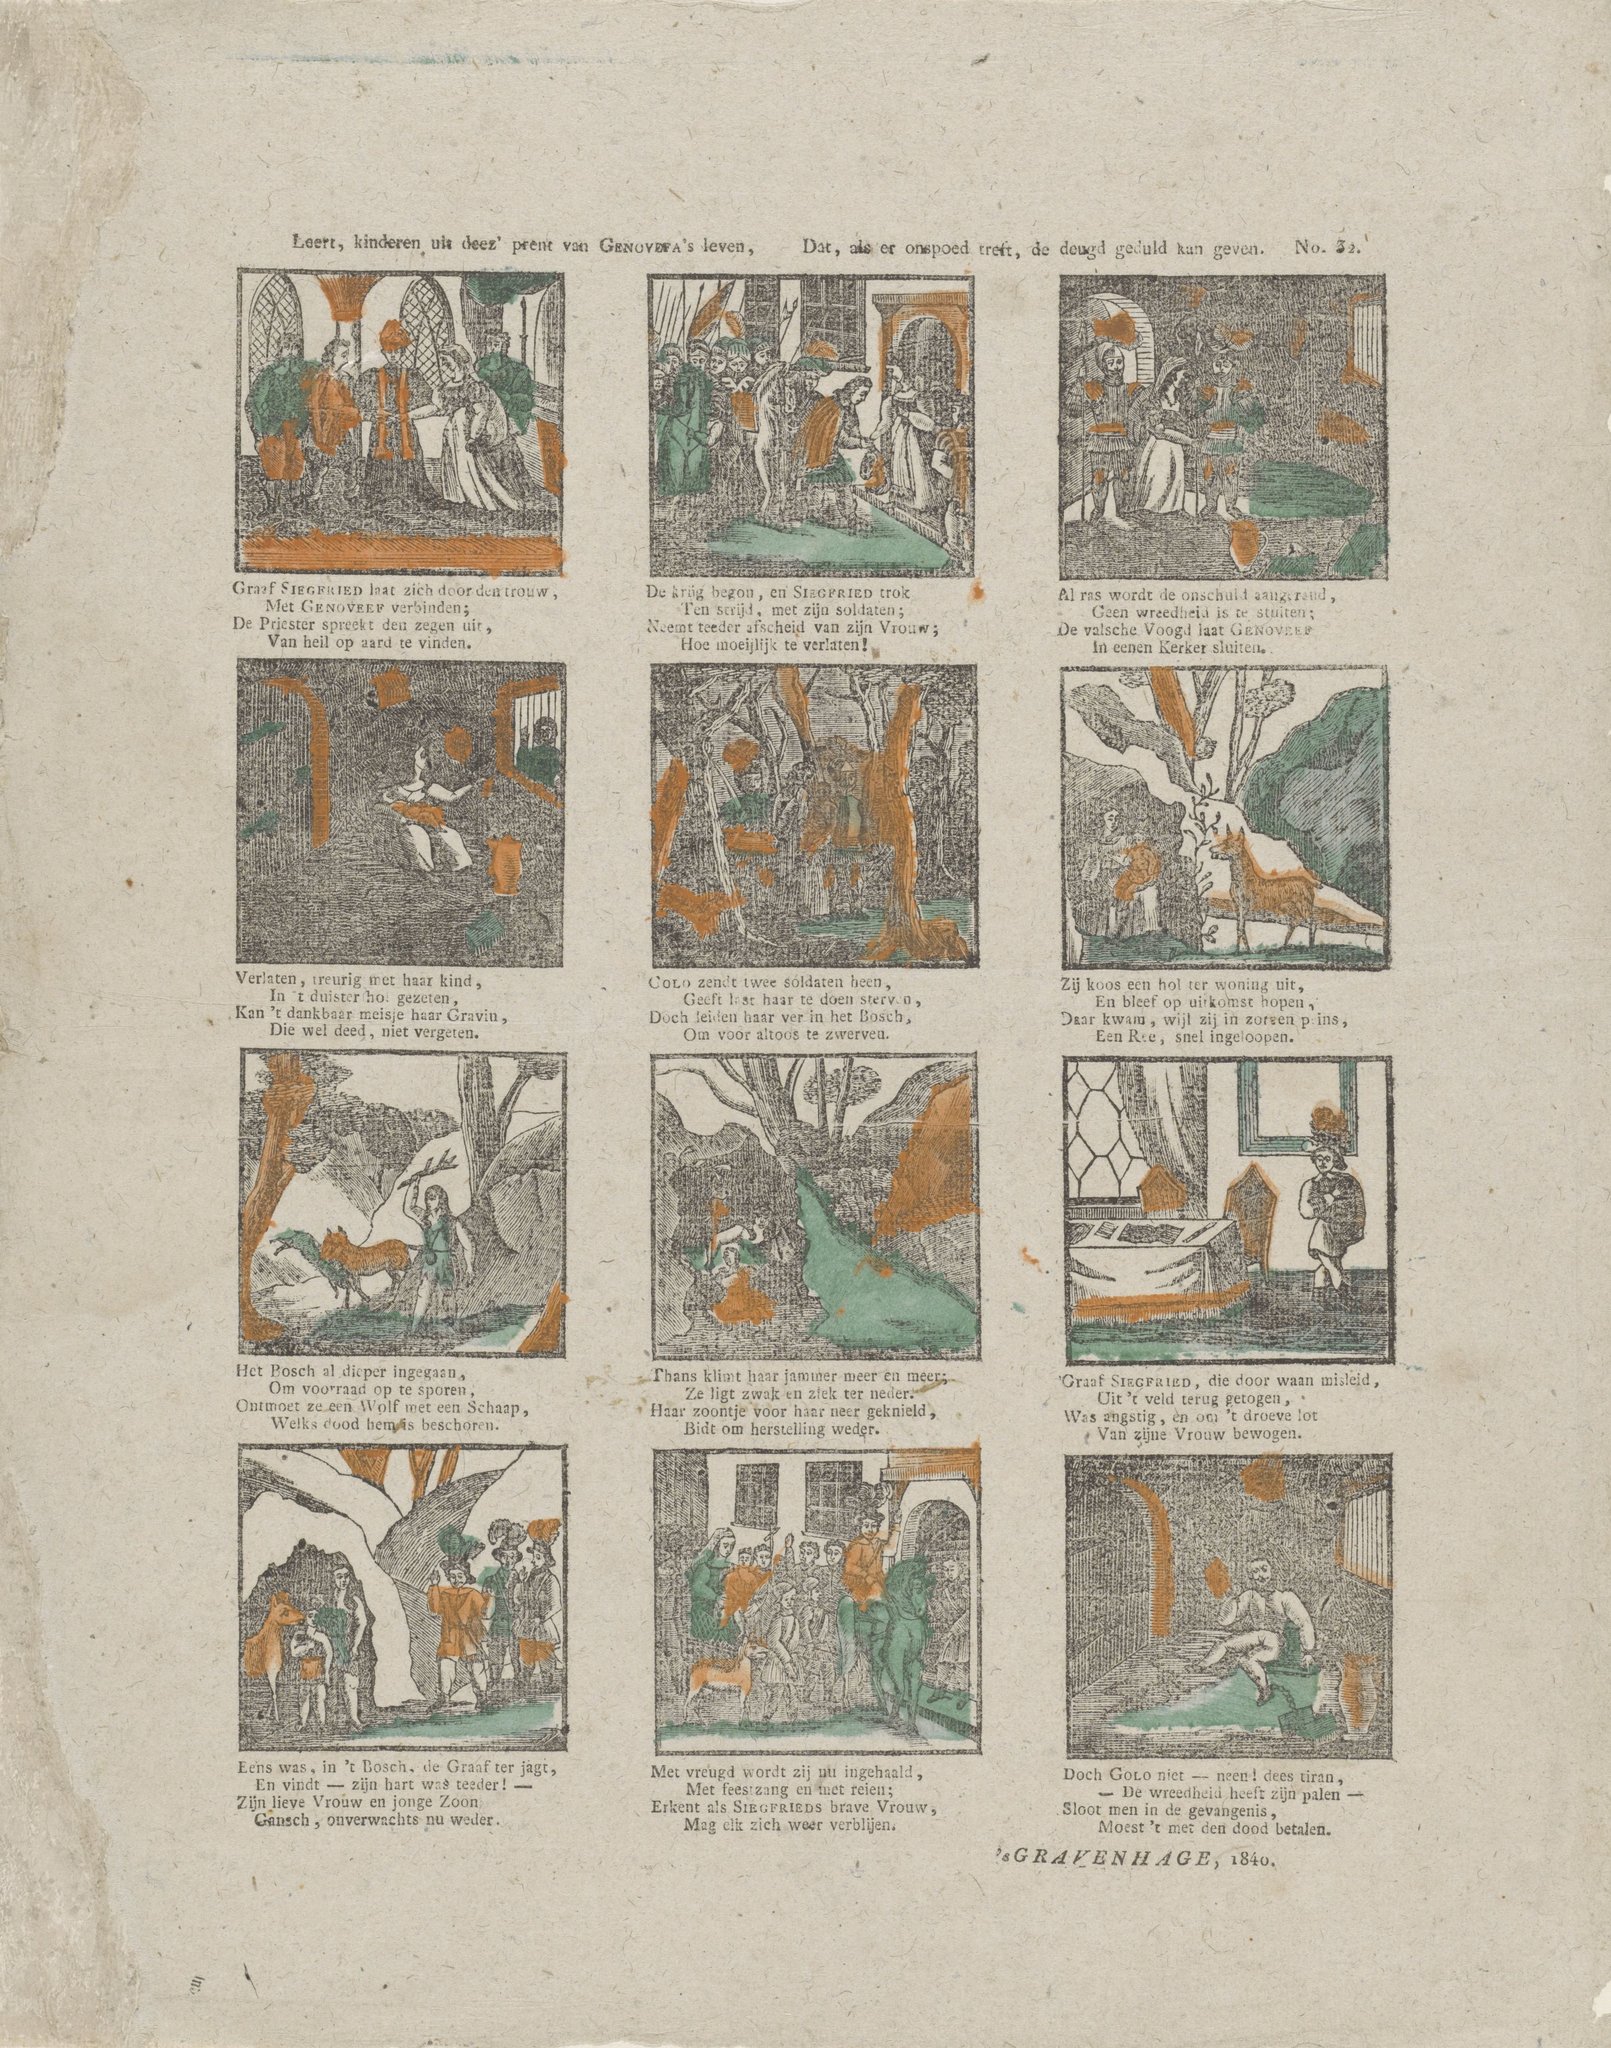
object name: print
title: Leert, kinderen uit deez' prent van Genoveva's leven, / Dat er onspoed treft, de deugd geduld kan geven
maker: Anonymous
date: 1840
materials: paper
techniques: colour, letterpress printing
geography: the hague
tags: genoveva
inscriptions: inscription: ‘Trijntje [...]eraar F.D.’, collector's mark: Lugt 2760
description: Blad met 12 voorstellingen over het leven van Genoveva van Brabant. Onder elke afbeelding een vierregelig vers. Genummerd rechtsboven: No. 52.